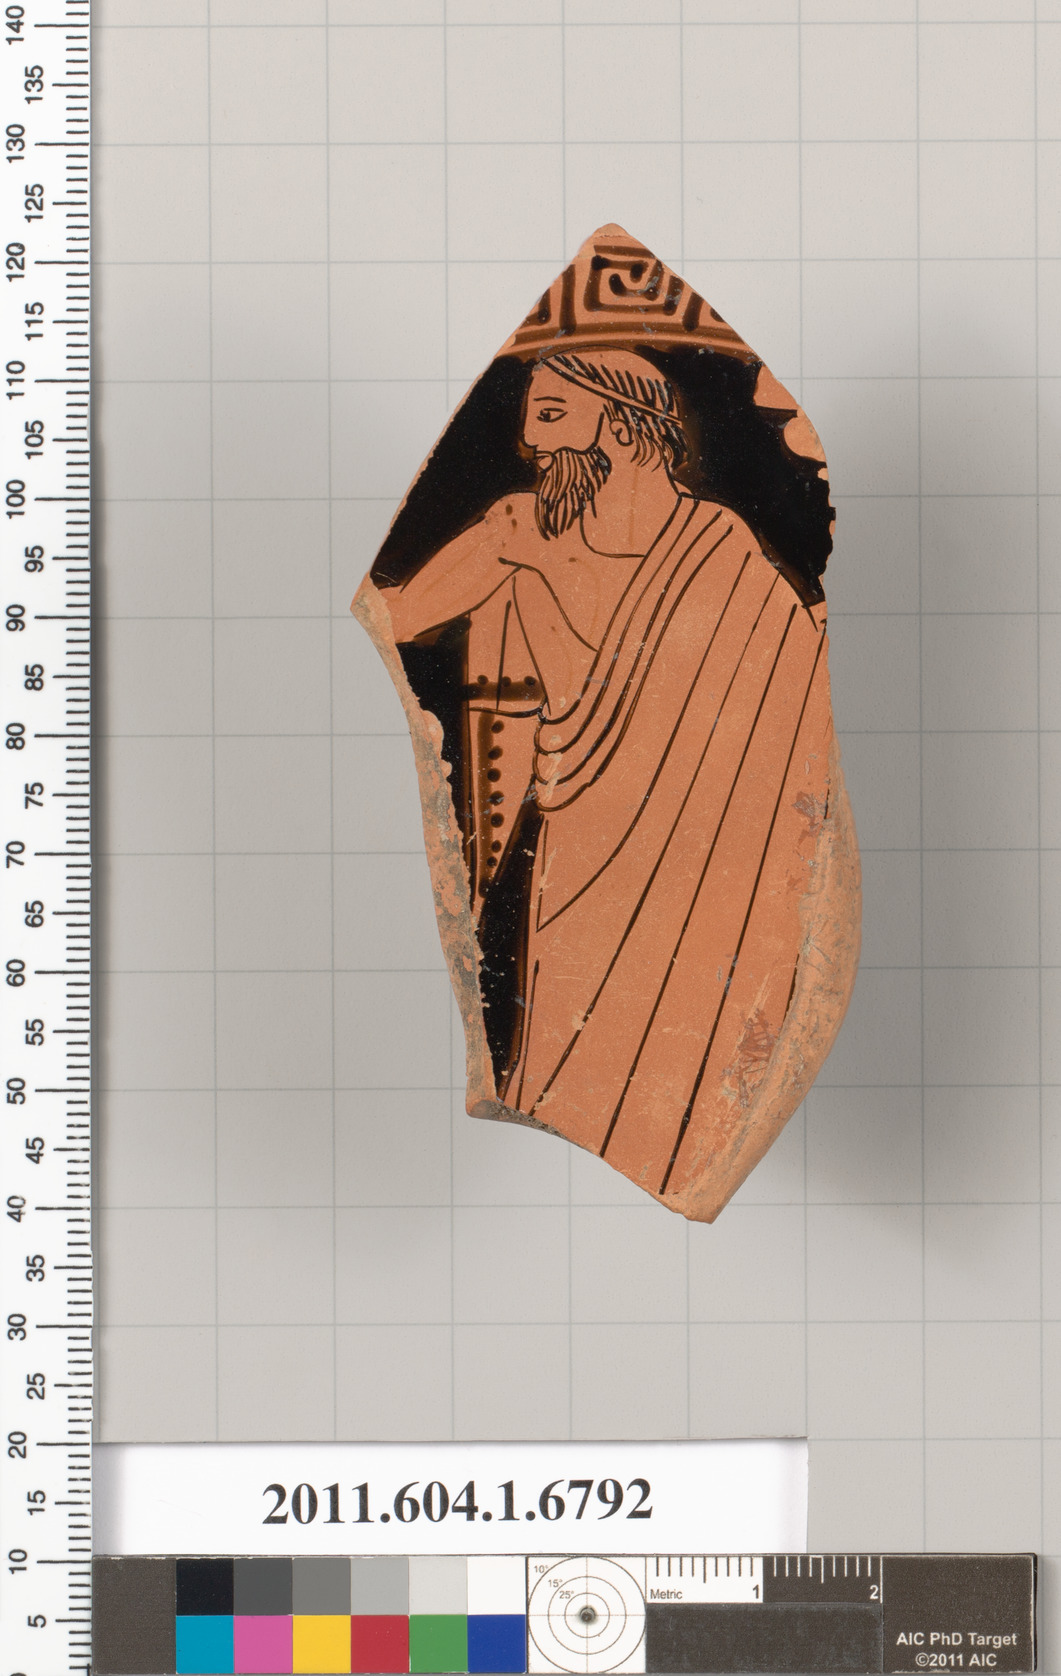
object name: kylix fragment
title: Terracotta fragment of a kylix (drinking cup)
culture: greek, attic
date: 470-460 BCE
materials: terracotta